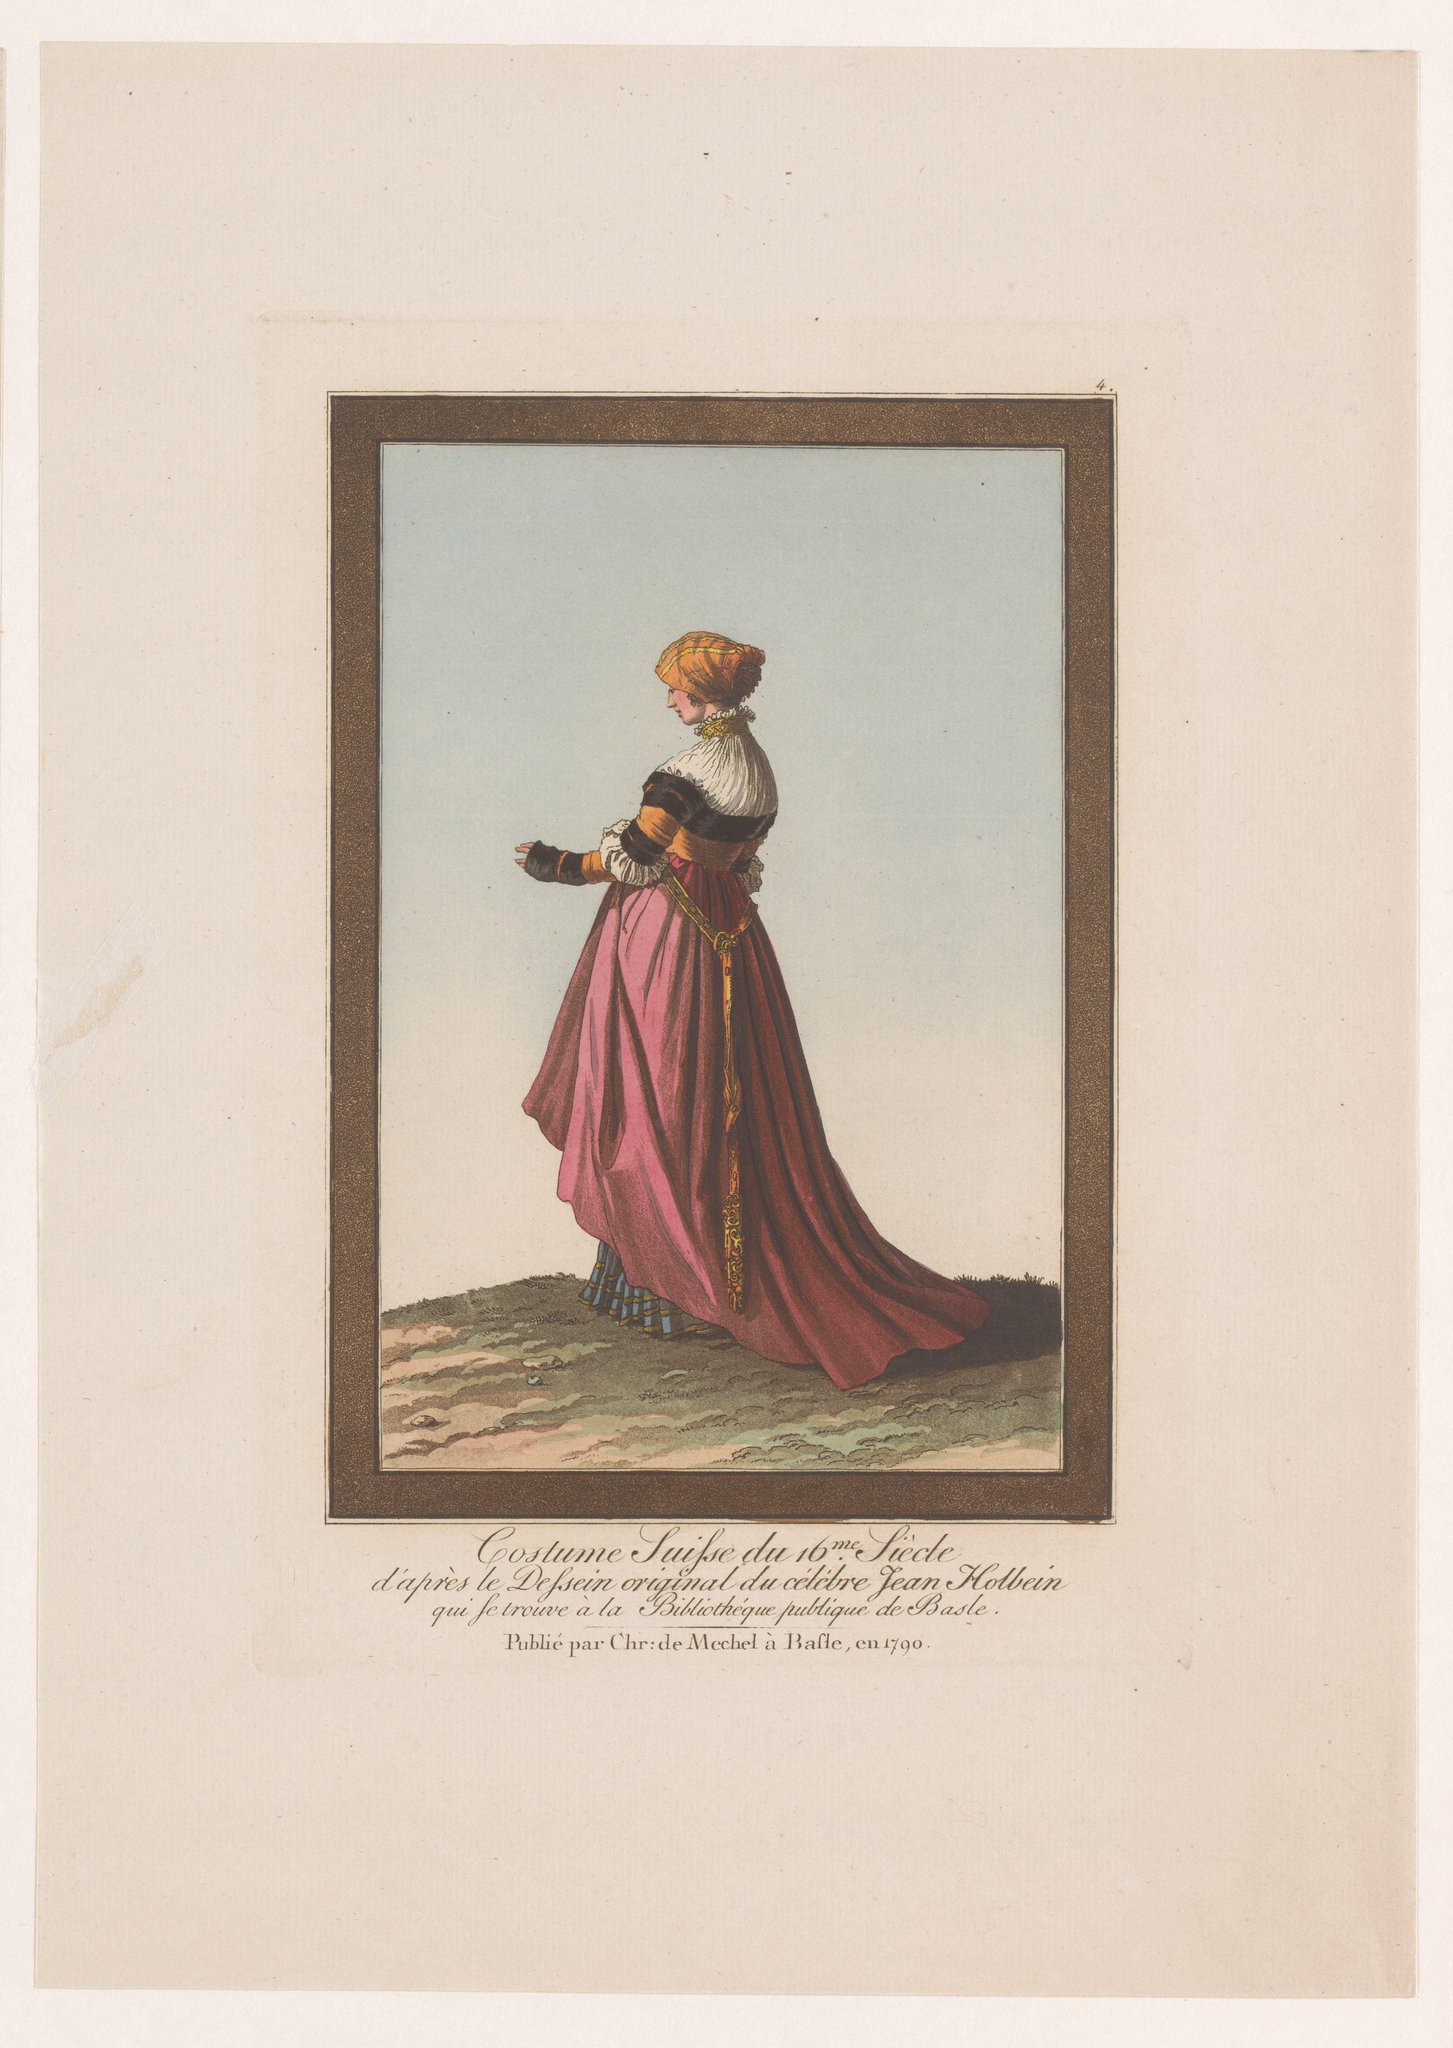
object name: print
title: Recueil de XII costumes Suisses civils et militaires, hommes et femmes, du seizième siècle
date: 1790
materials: paper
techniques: aquatint, etching, hand coloring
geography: basel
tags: dress, gown: court gown or court dress, clothes, costume, switzerland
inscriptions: collector's mark: Lugt 2228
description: De serie behoort tot de 4-delige publicatie 'Oeuvre de Jean Holbein', Bazel 1780-1795, door Christian von Mechel.